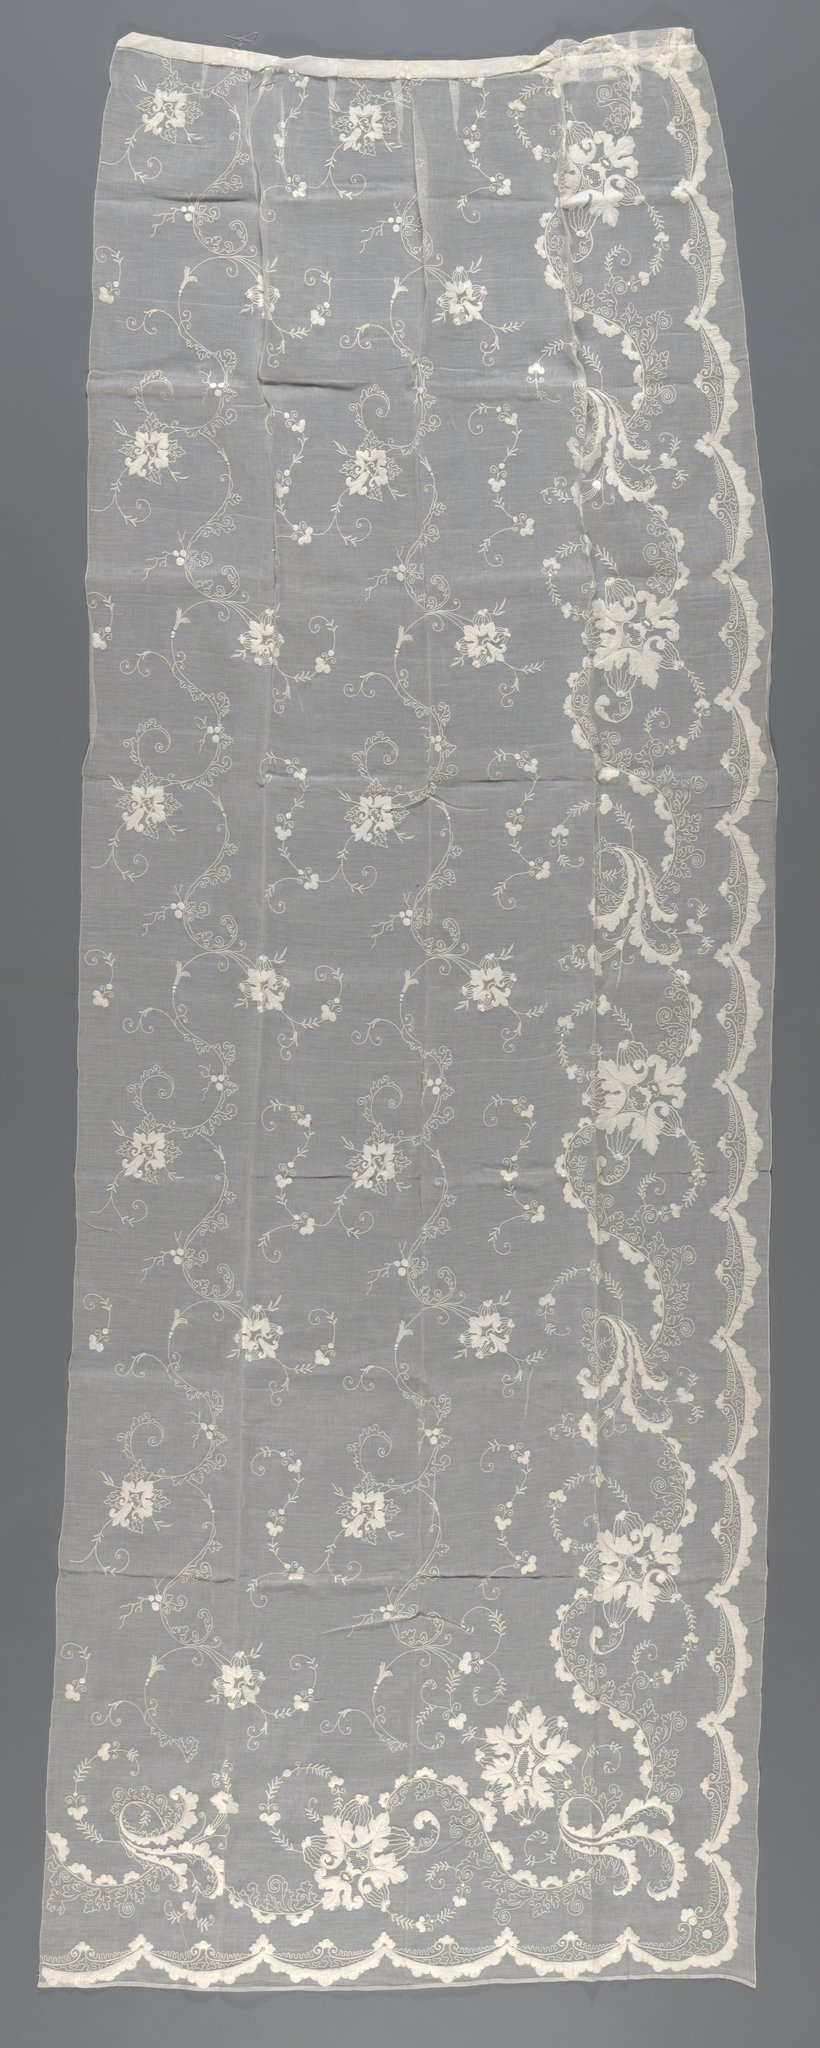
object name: bed curtain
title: Bedgordijn van glasbatist, versierd met tule doorstopborduursel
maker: Anonymous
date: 1800-1874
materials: textile, copper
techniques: stopwork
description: Bedgordijn van glasbatist, versierd met tule doorstopborduursel (wit op wit) in de vorm van bloemornament en voluten. Aangenaaid linnen band met drie koperen ringen.